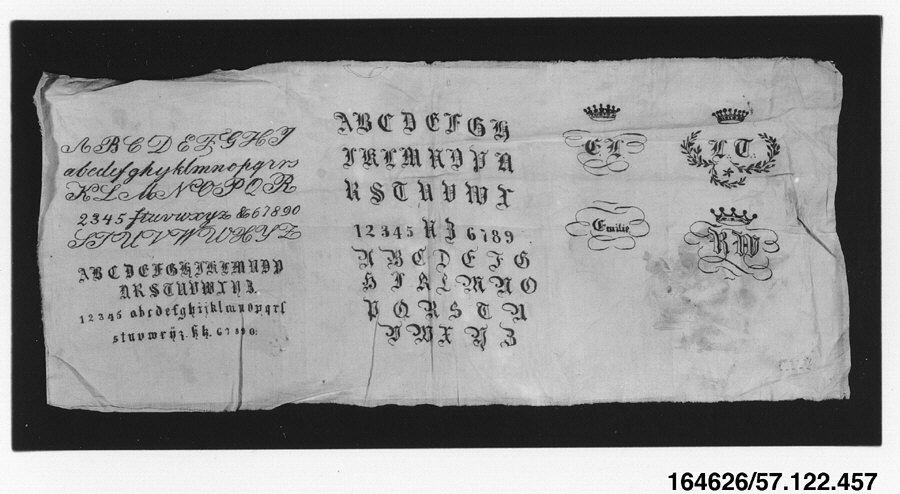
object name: sampler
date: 1801-1900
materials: cotton